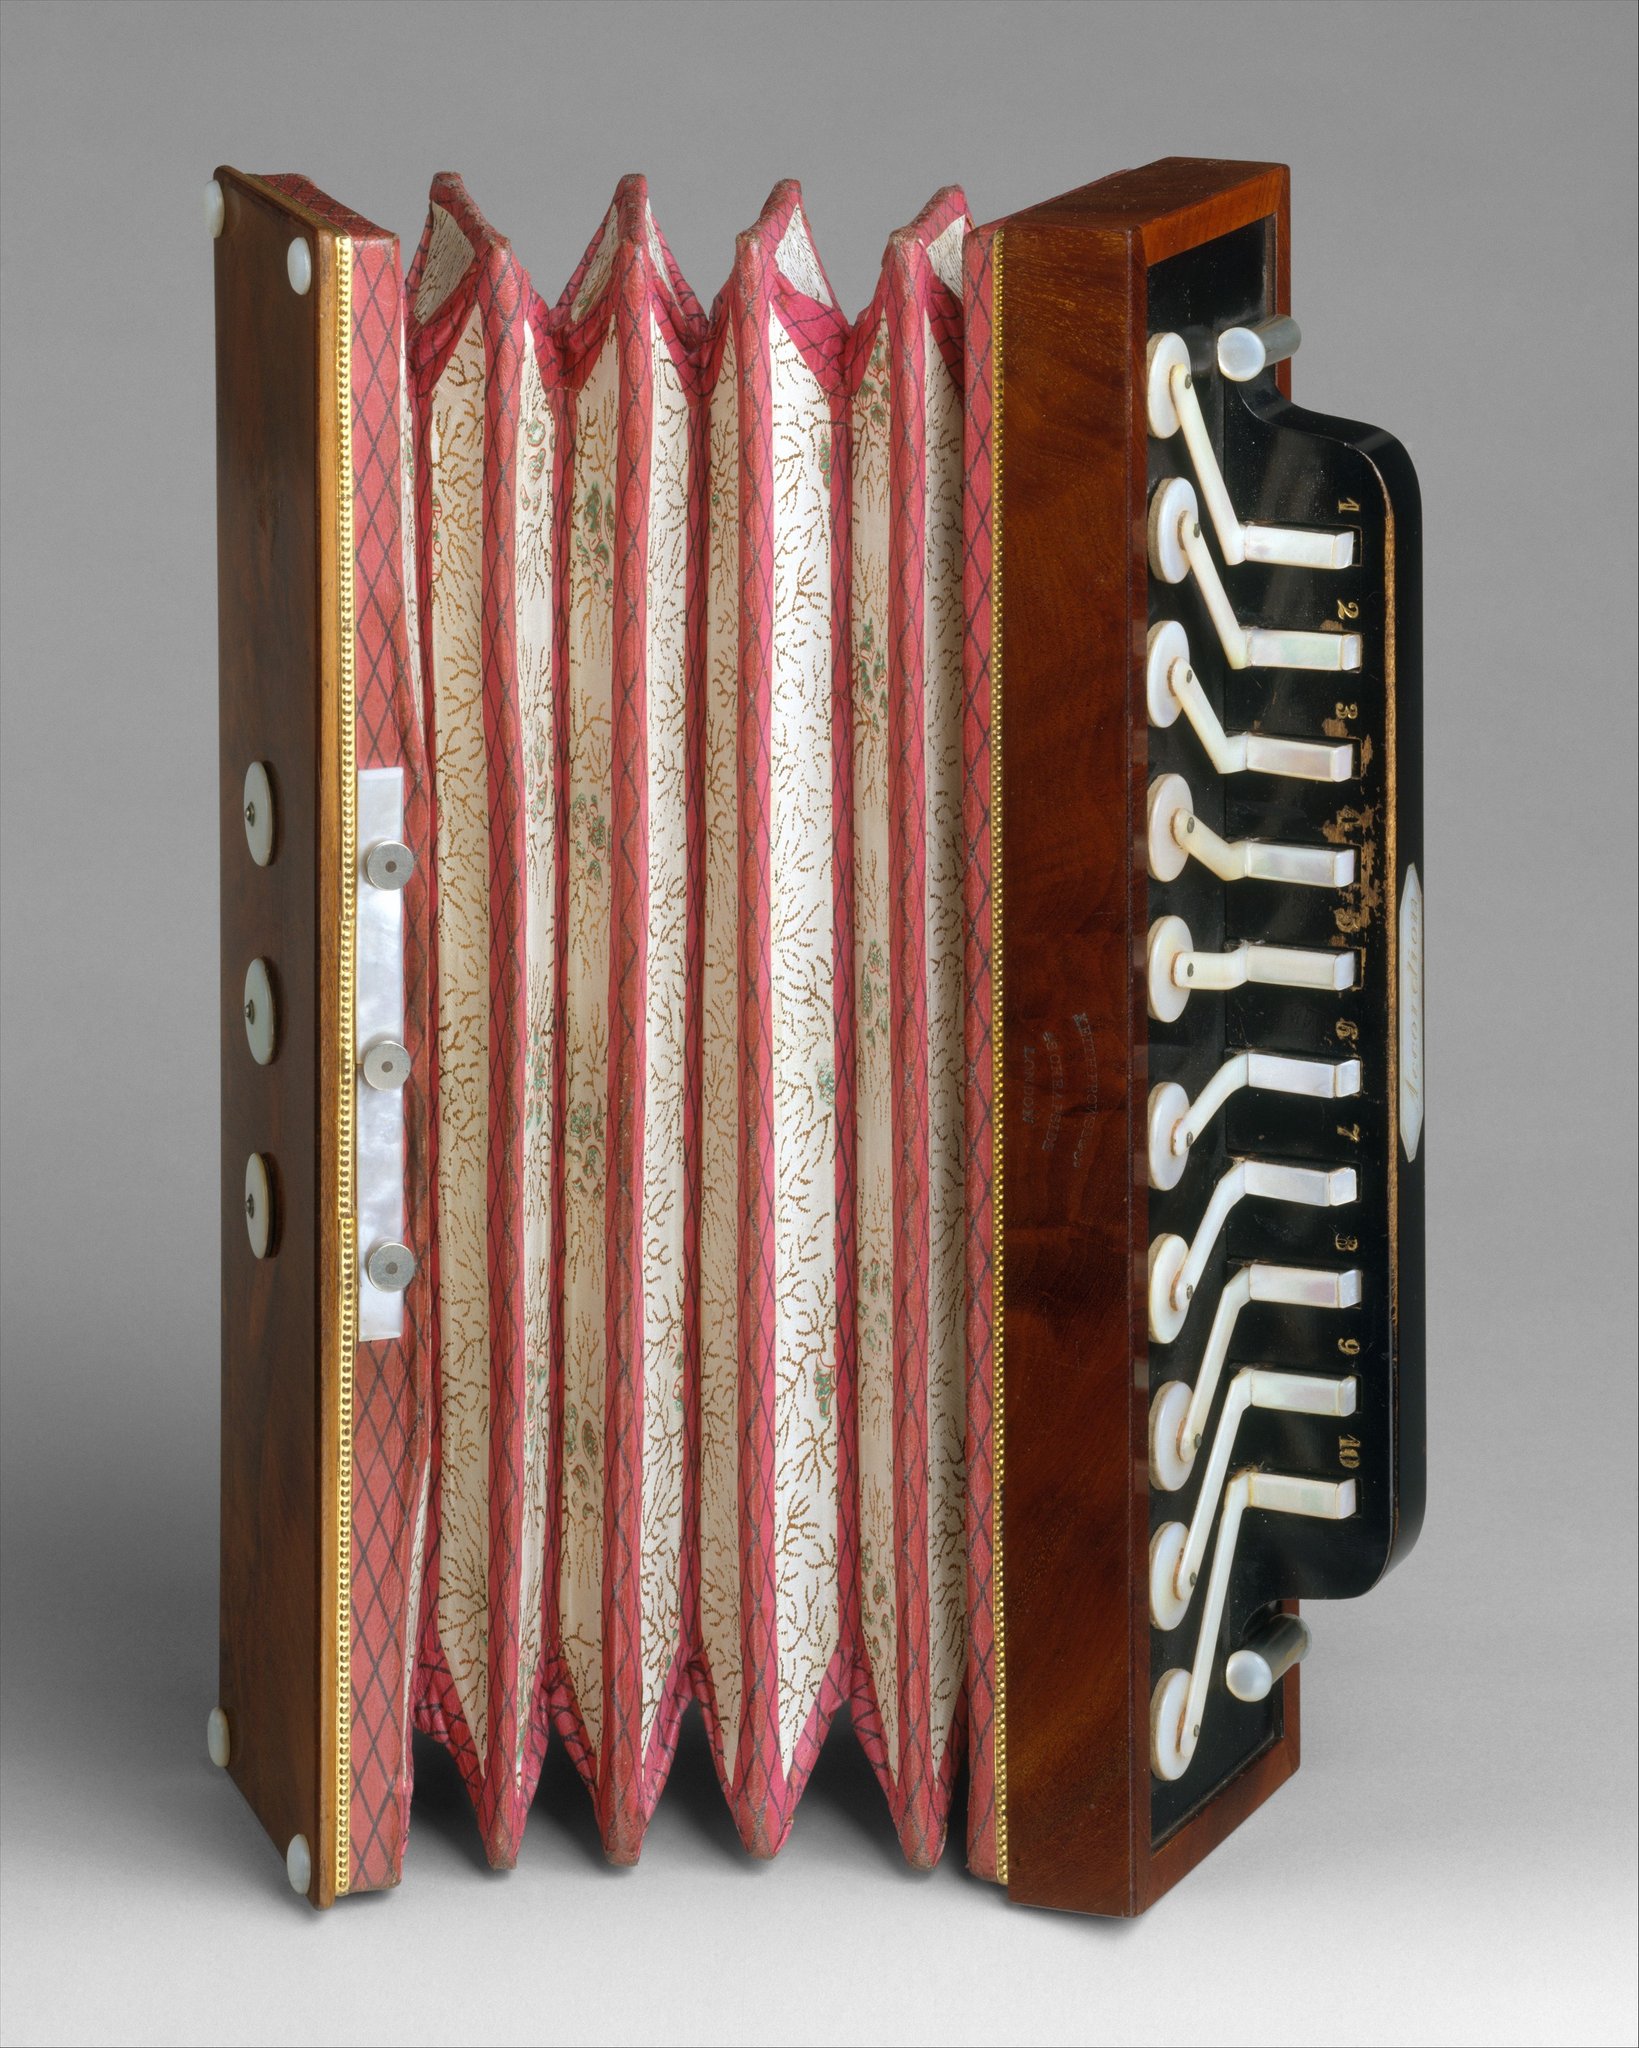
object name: accordion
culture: british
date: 1835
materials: leather, wood, paper, shell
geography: united kingdom